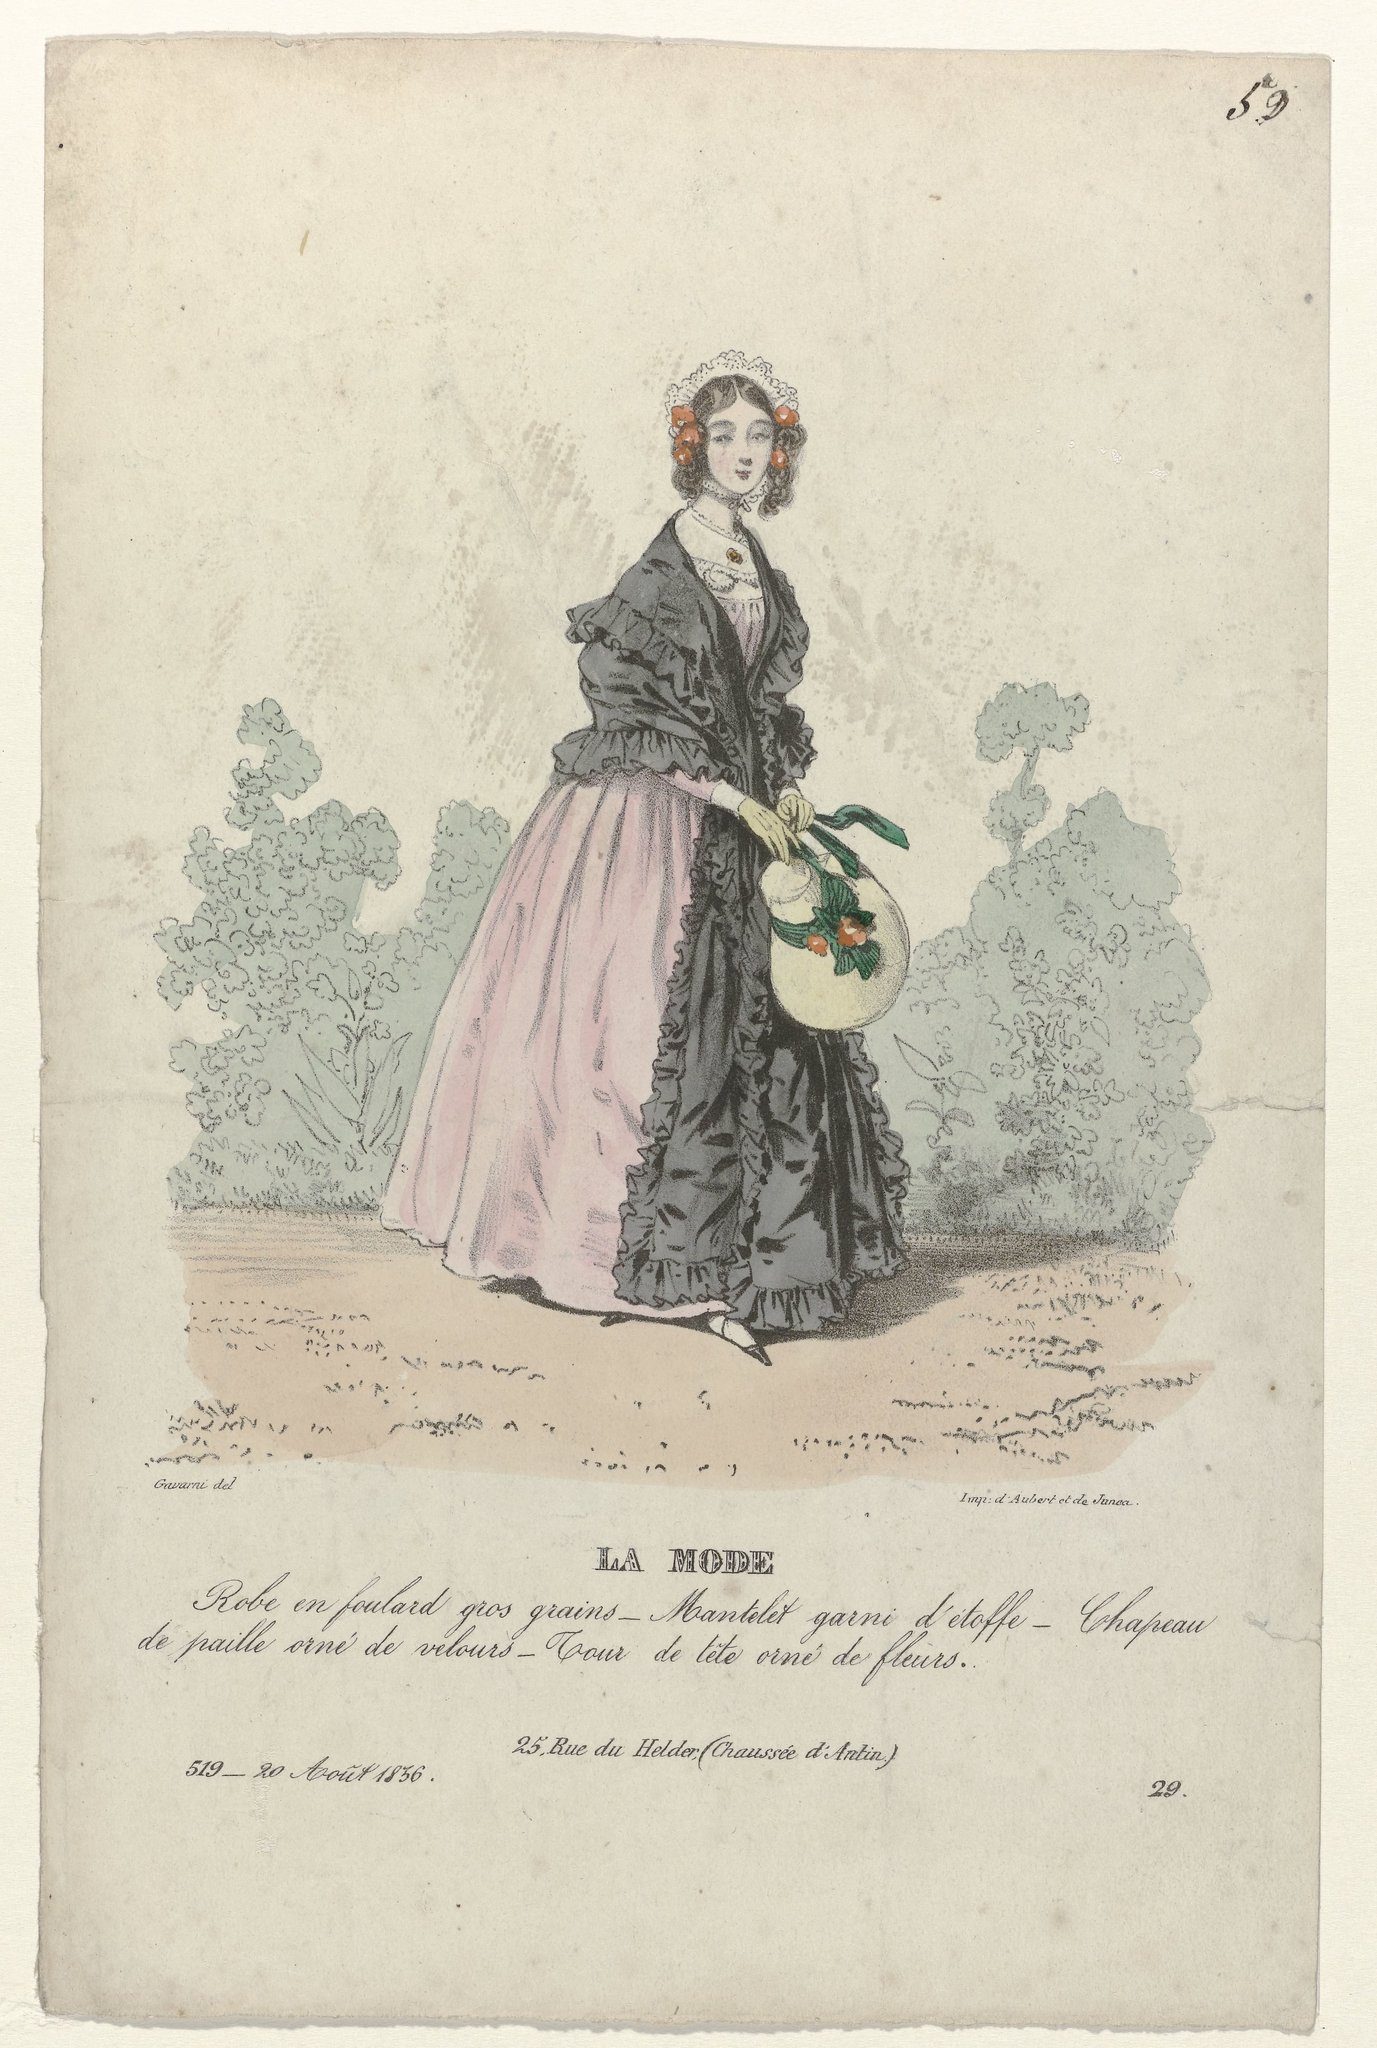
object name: fashion print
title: La Mode, 20 août 1836, No. 519: Robe en poulard gros graines (...)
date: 1836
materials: paper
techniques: hand coloring, lithograph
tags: flowers, clothing for the upper part of the body (mantelet) (+ women's clothes), fashion plates, head-gear: hat (+ women's clothes), gloves, mittens, etc. (+ women's clothes), dress, gown (+ women's clothes), neck-gear ~ clothing (+ women's clothes)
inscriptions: address: ‘25, Rue du Helder (Chaussée d'Antin)’, caption: ‘Robe en foulard gros grains _ Mantelet garni d'etoffe _ Chapeau de paille orné de velours _ Tour de tête orné de fleurs.’, title: ‘La Mode’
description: Japon van 'foulard gros grains'. Kleine schoudermantel, afgezet met gerimpelde stroken stof. Luifelhoed van stro versierd met fluweel. Hoofdband versierd met bloemen. Prent uit het modetijdschrift La Mode (1829-1855).